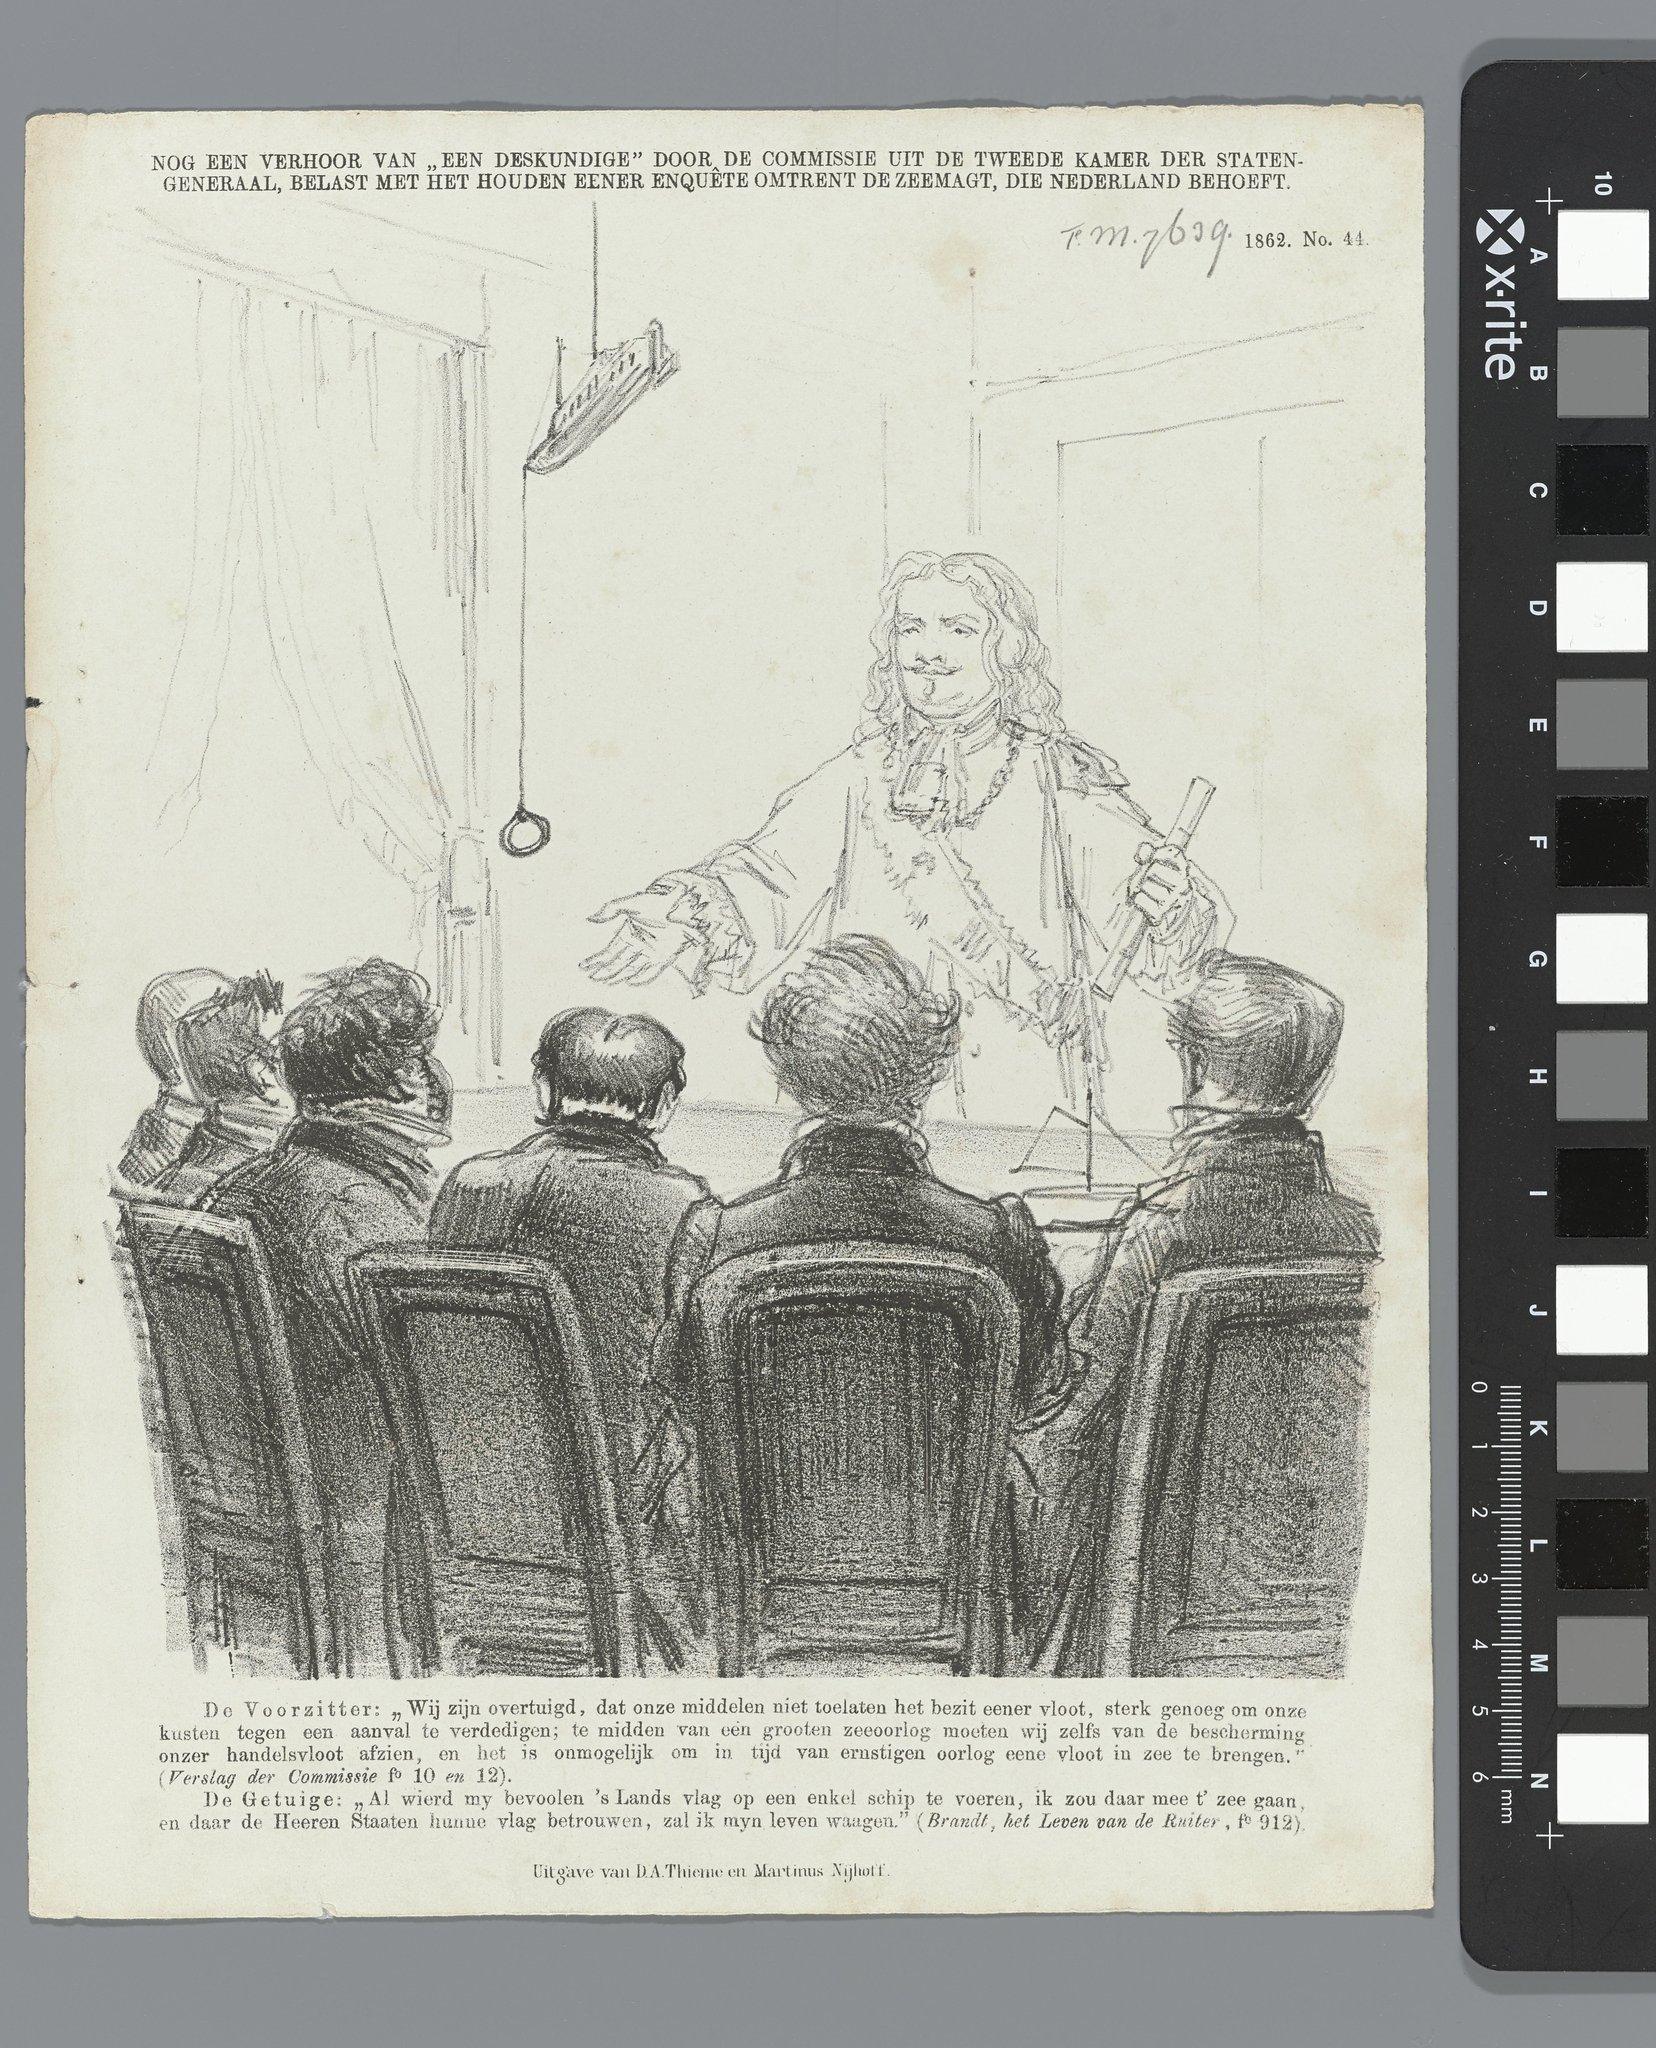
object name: cartoon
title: Nog een verhoor van "een deskundige" door de commissie uit de Tweede Kamer der Staten-Generaal, belast met het houden eener enquête omtrent de zeemagt, die Nederland behoeft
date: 1862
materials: paper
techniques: lithograph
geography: netherlands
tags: flushing, michiel adriaenszoon de ruyter, navy, committee members, board members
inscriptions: collector's mark: Lugt 2228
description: Spotprent op de parlementaire enquêtecommissie naar de toestand van de zeemacht. De geest van Michiel Adriaenszoon de Ruyter verschijnt voor de commissie. Plaat verschenen bij het weekblad De Nederlandsche Spectator, nr. 44, 1 november 1862.